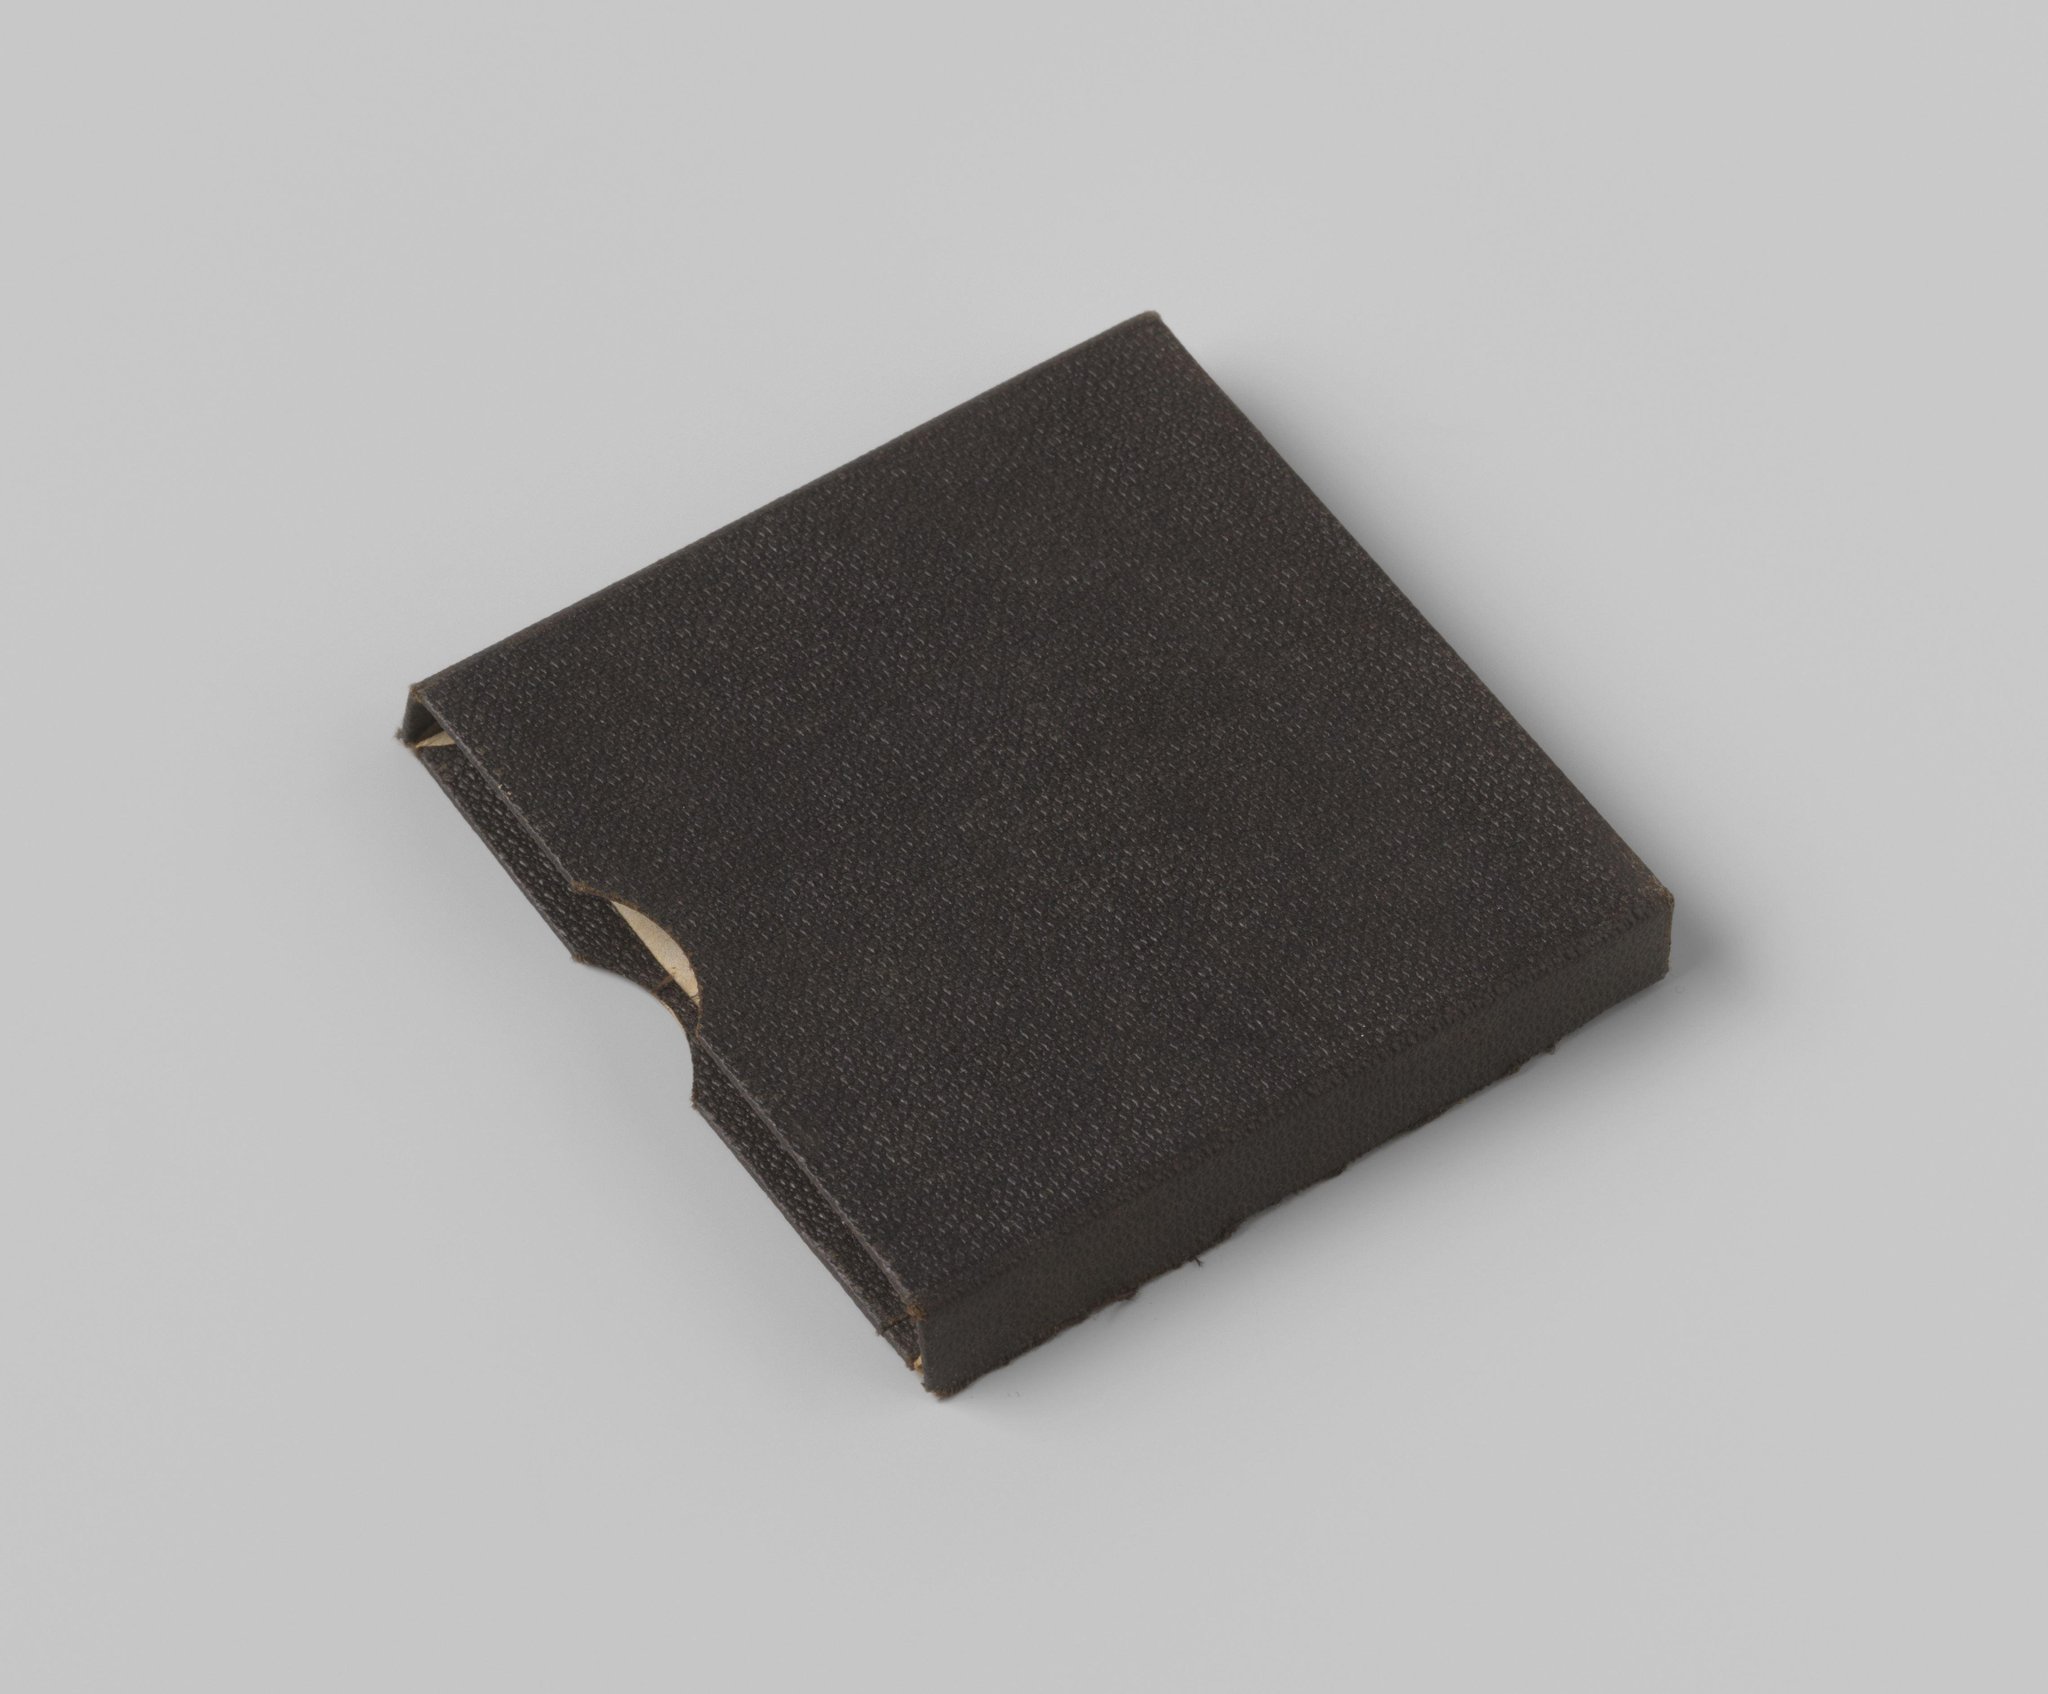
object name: box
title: Doosje behorend bij een penning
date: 1887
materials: leather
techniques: striking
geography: utrecht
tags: utrecht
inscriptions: signature: ‘L. JÜNGER D.; J.P.M. MENGER F.’, inscription: ‘HULDE NA XL JAREN / VAN VRUCHTBARE / AKADEMISCHE / WERKZAAMHEID / XVI NOV. / MDCCCXLVII - MDCCCLXXXVII’, inscription: ‘CHRISTPH. HENDR. DID. BUIJS BALLOT’, signature: ‘W.S.’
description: Vierkant leren doosje behorend bij een bronzen penning